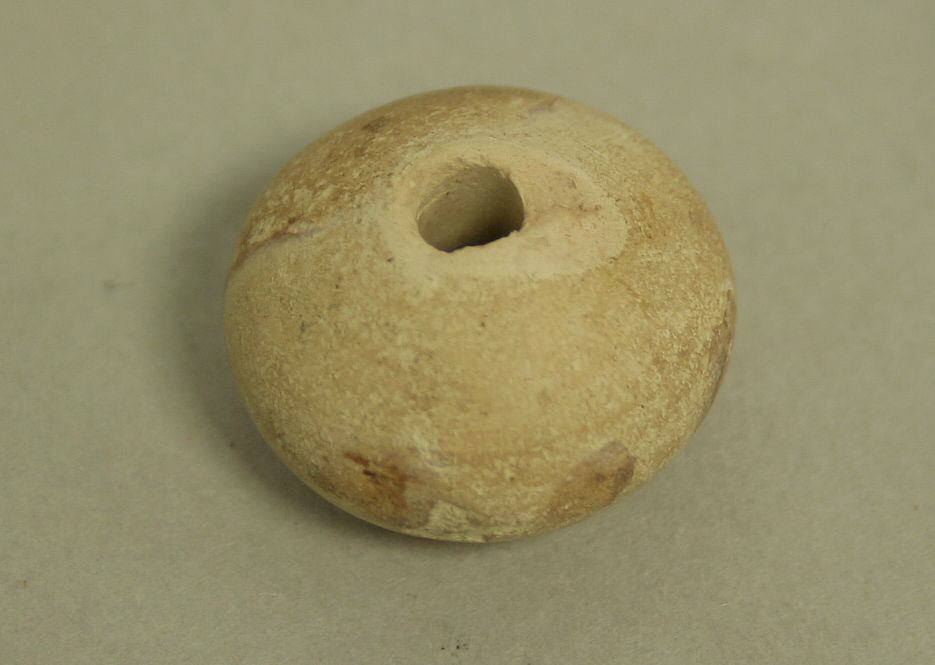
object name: spindle whorl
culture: peruvian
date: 1-500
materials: ceramic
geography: peru